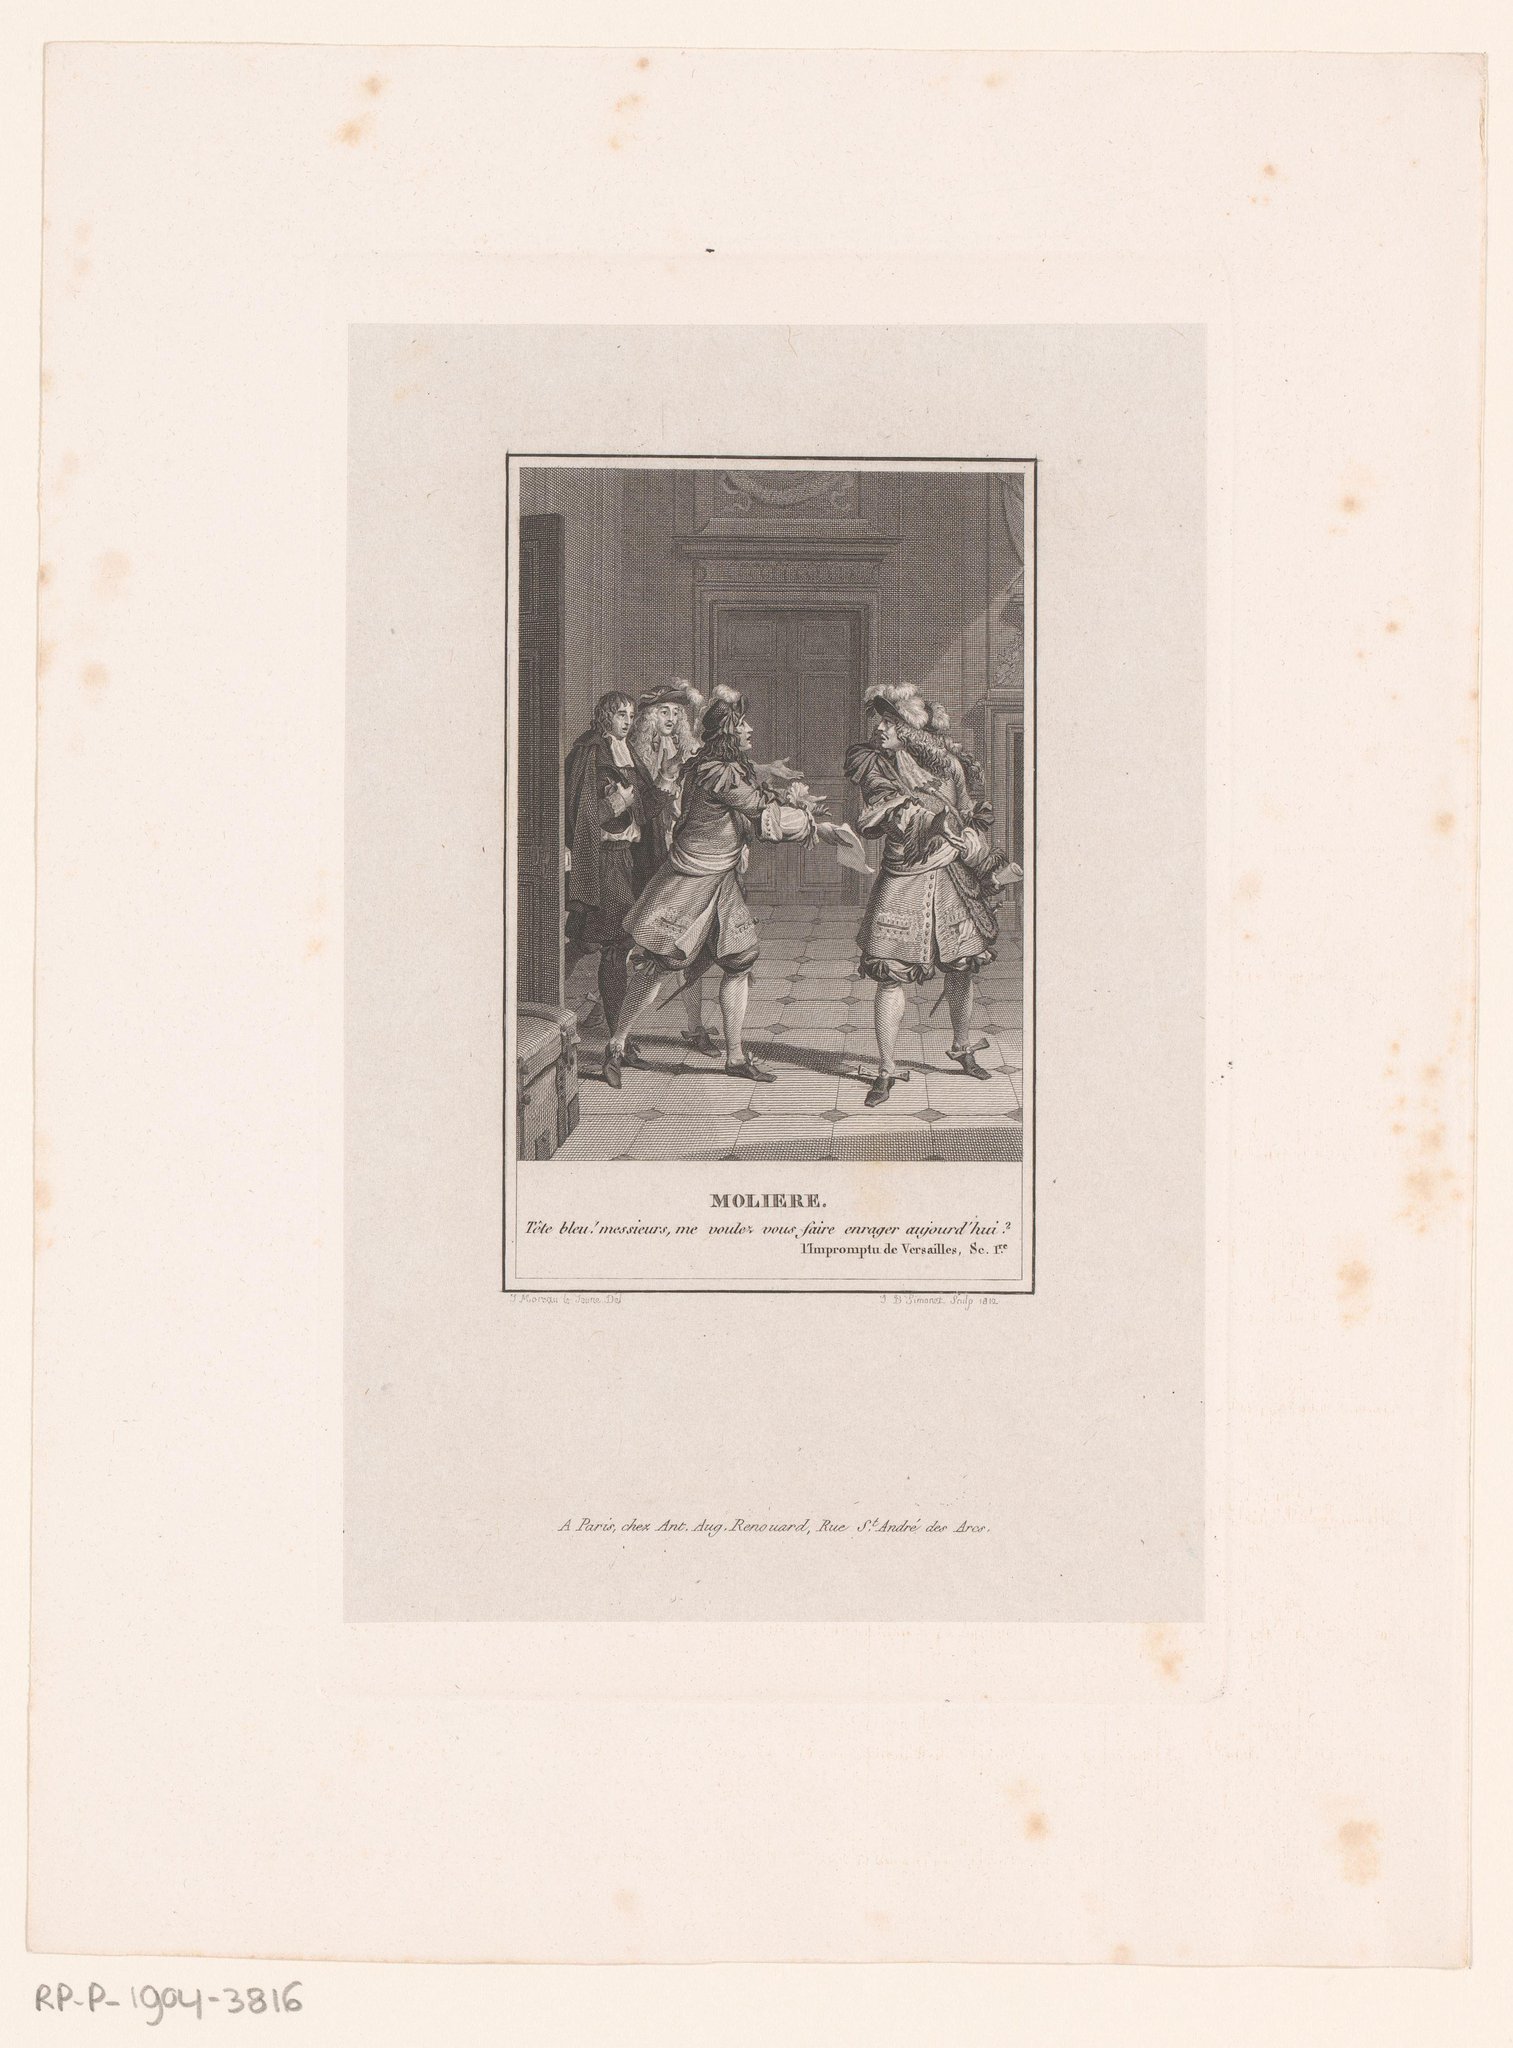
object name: print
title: Interieur met een galante heer in discussie met drie anderen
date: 1811-1813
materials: paper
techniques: engraving, etching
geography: france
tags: comedy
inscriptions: collector's mark: Lugt 2228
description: Prent van scène één uit 'L'Impromptu de Versailles' door Jean Baptiste Molière. Dit betreft één van de dertig prenten, gemaakt in opdracht van Antoine Augustin Renouard, bestemd voor verschillende edities van Molières werk daterend van 1811 tot 1813. De prenten zijn vervaardigd door verschillende kunstenaars naar composities van Moreau.